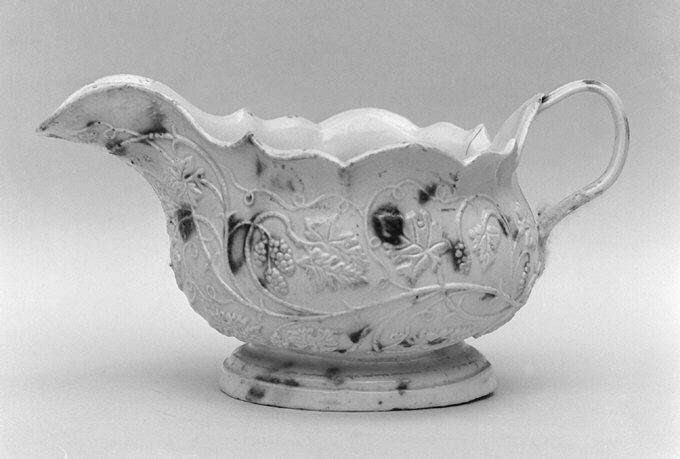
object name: sauceboat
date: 1745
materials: stoneware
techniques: salt glaze